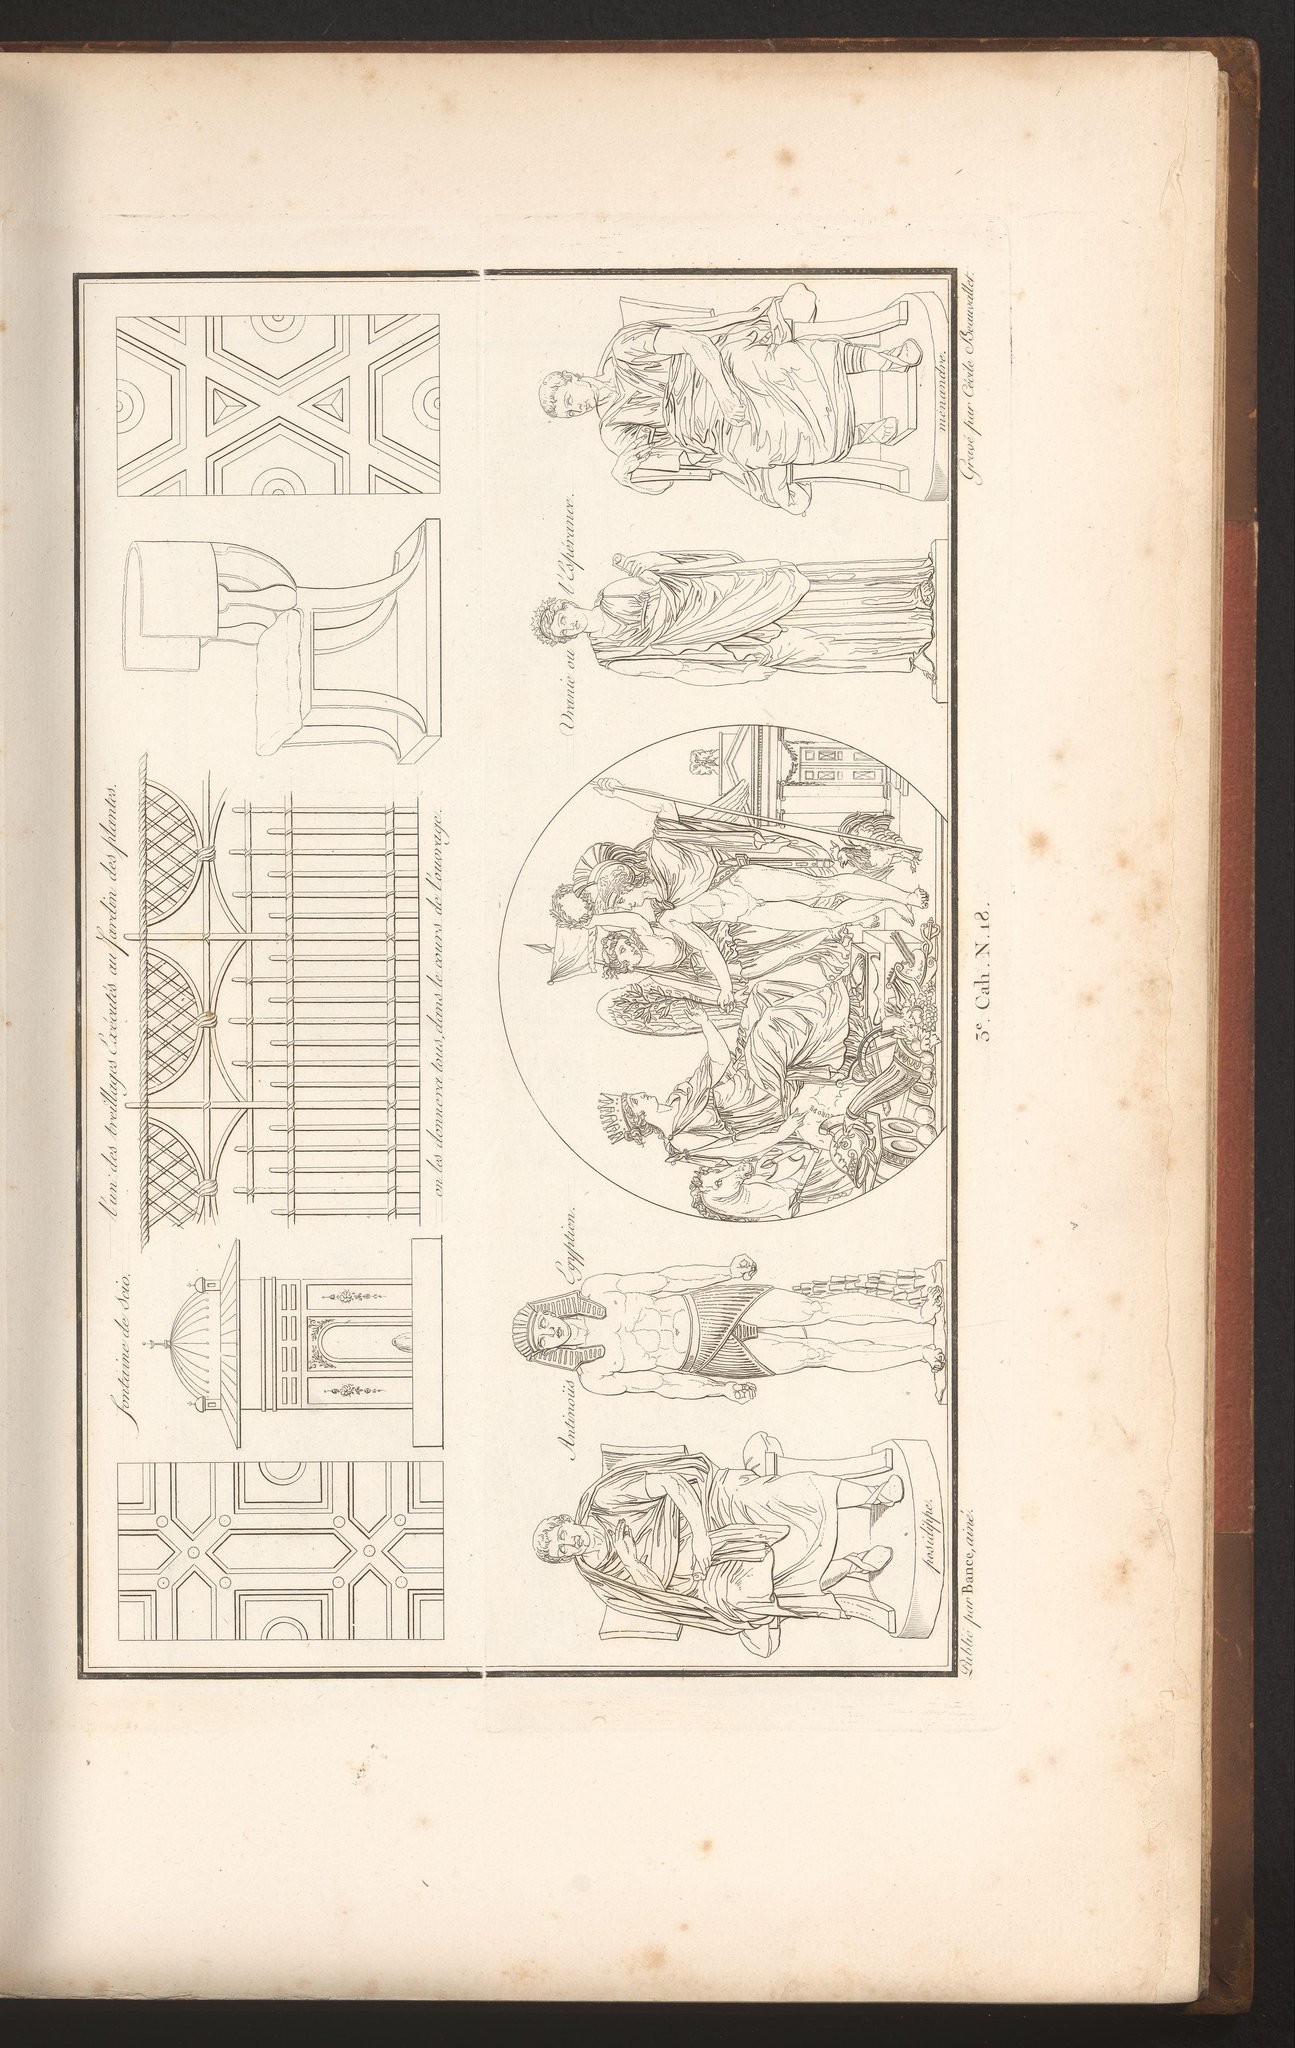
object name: ornament print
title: Romeinse en Egyptische figuren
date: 1820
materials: paper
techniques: etching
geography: paris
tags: ornaments ~ art, representations ~ egyptian gods, demi-gods, heroes, etc., classical history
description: Ornamentprent met Romeinse en Egyptische figuren en diverse andere ornamenten. Onderdeel (3e. Cah. N. 18) van het prentalbum met twee series van in totaal 138 ornamentprenten door Beauvallet en Normand, 'Fragmens d'Ornemens dans le Style Antique'.